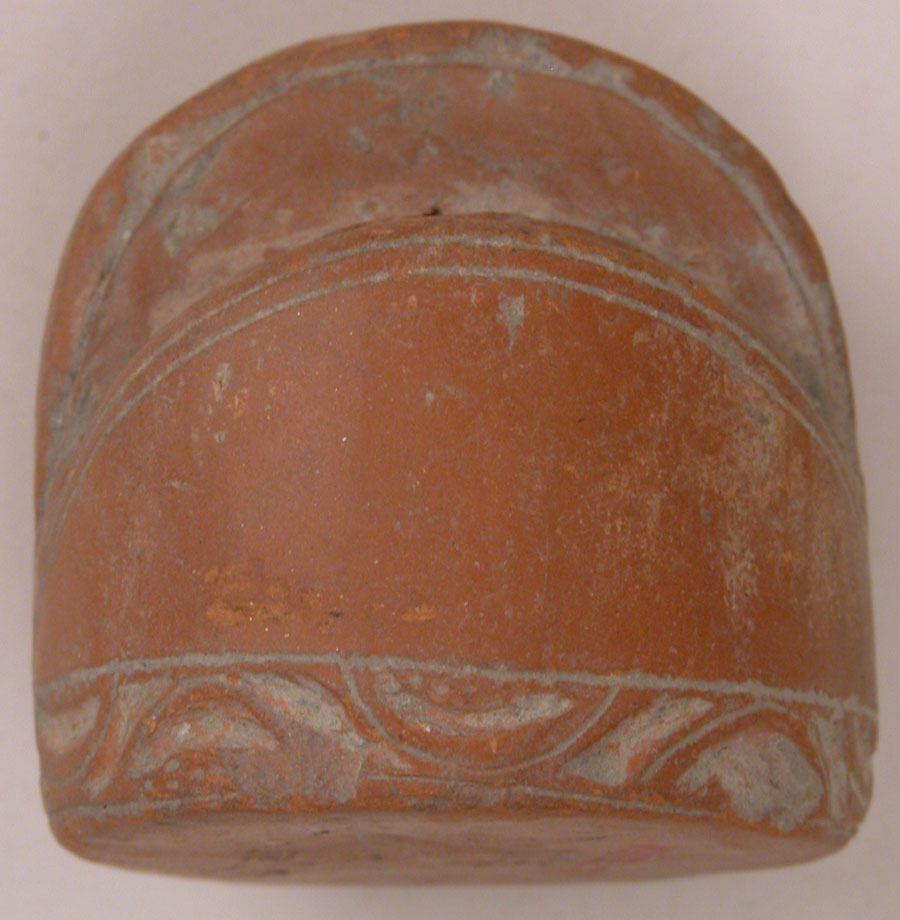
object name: chess piece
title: Chess Piece, King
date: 1001-1200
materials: terracotta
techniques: incising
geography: iran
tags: chess